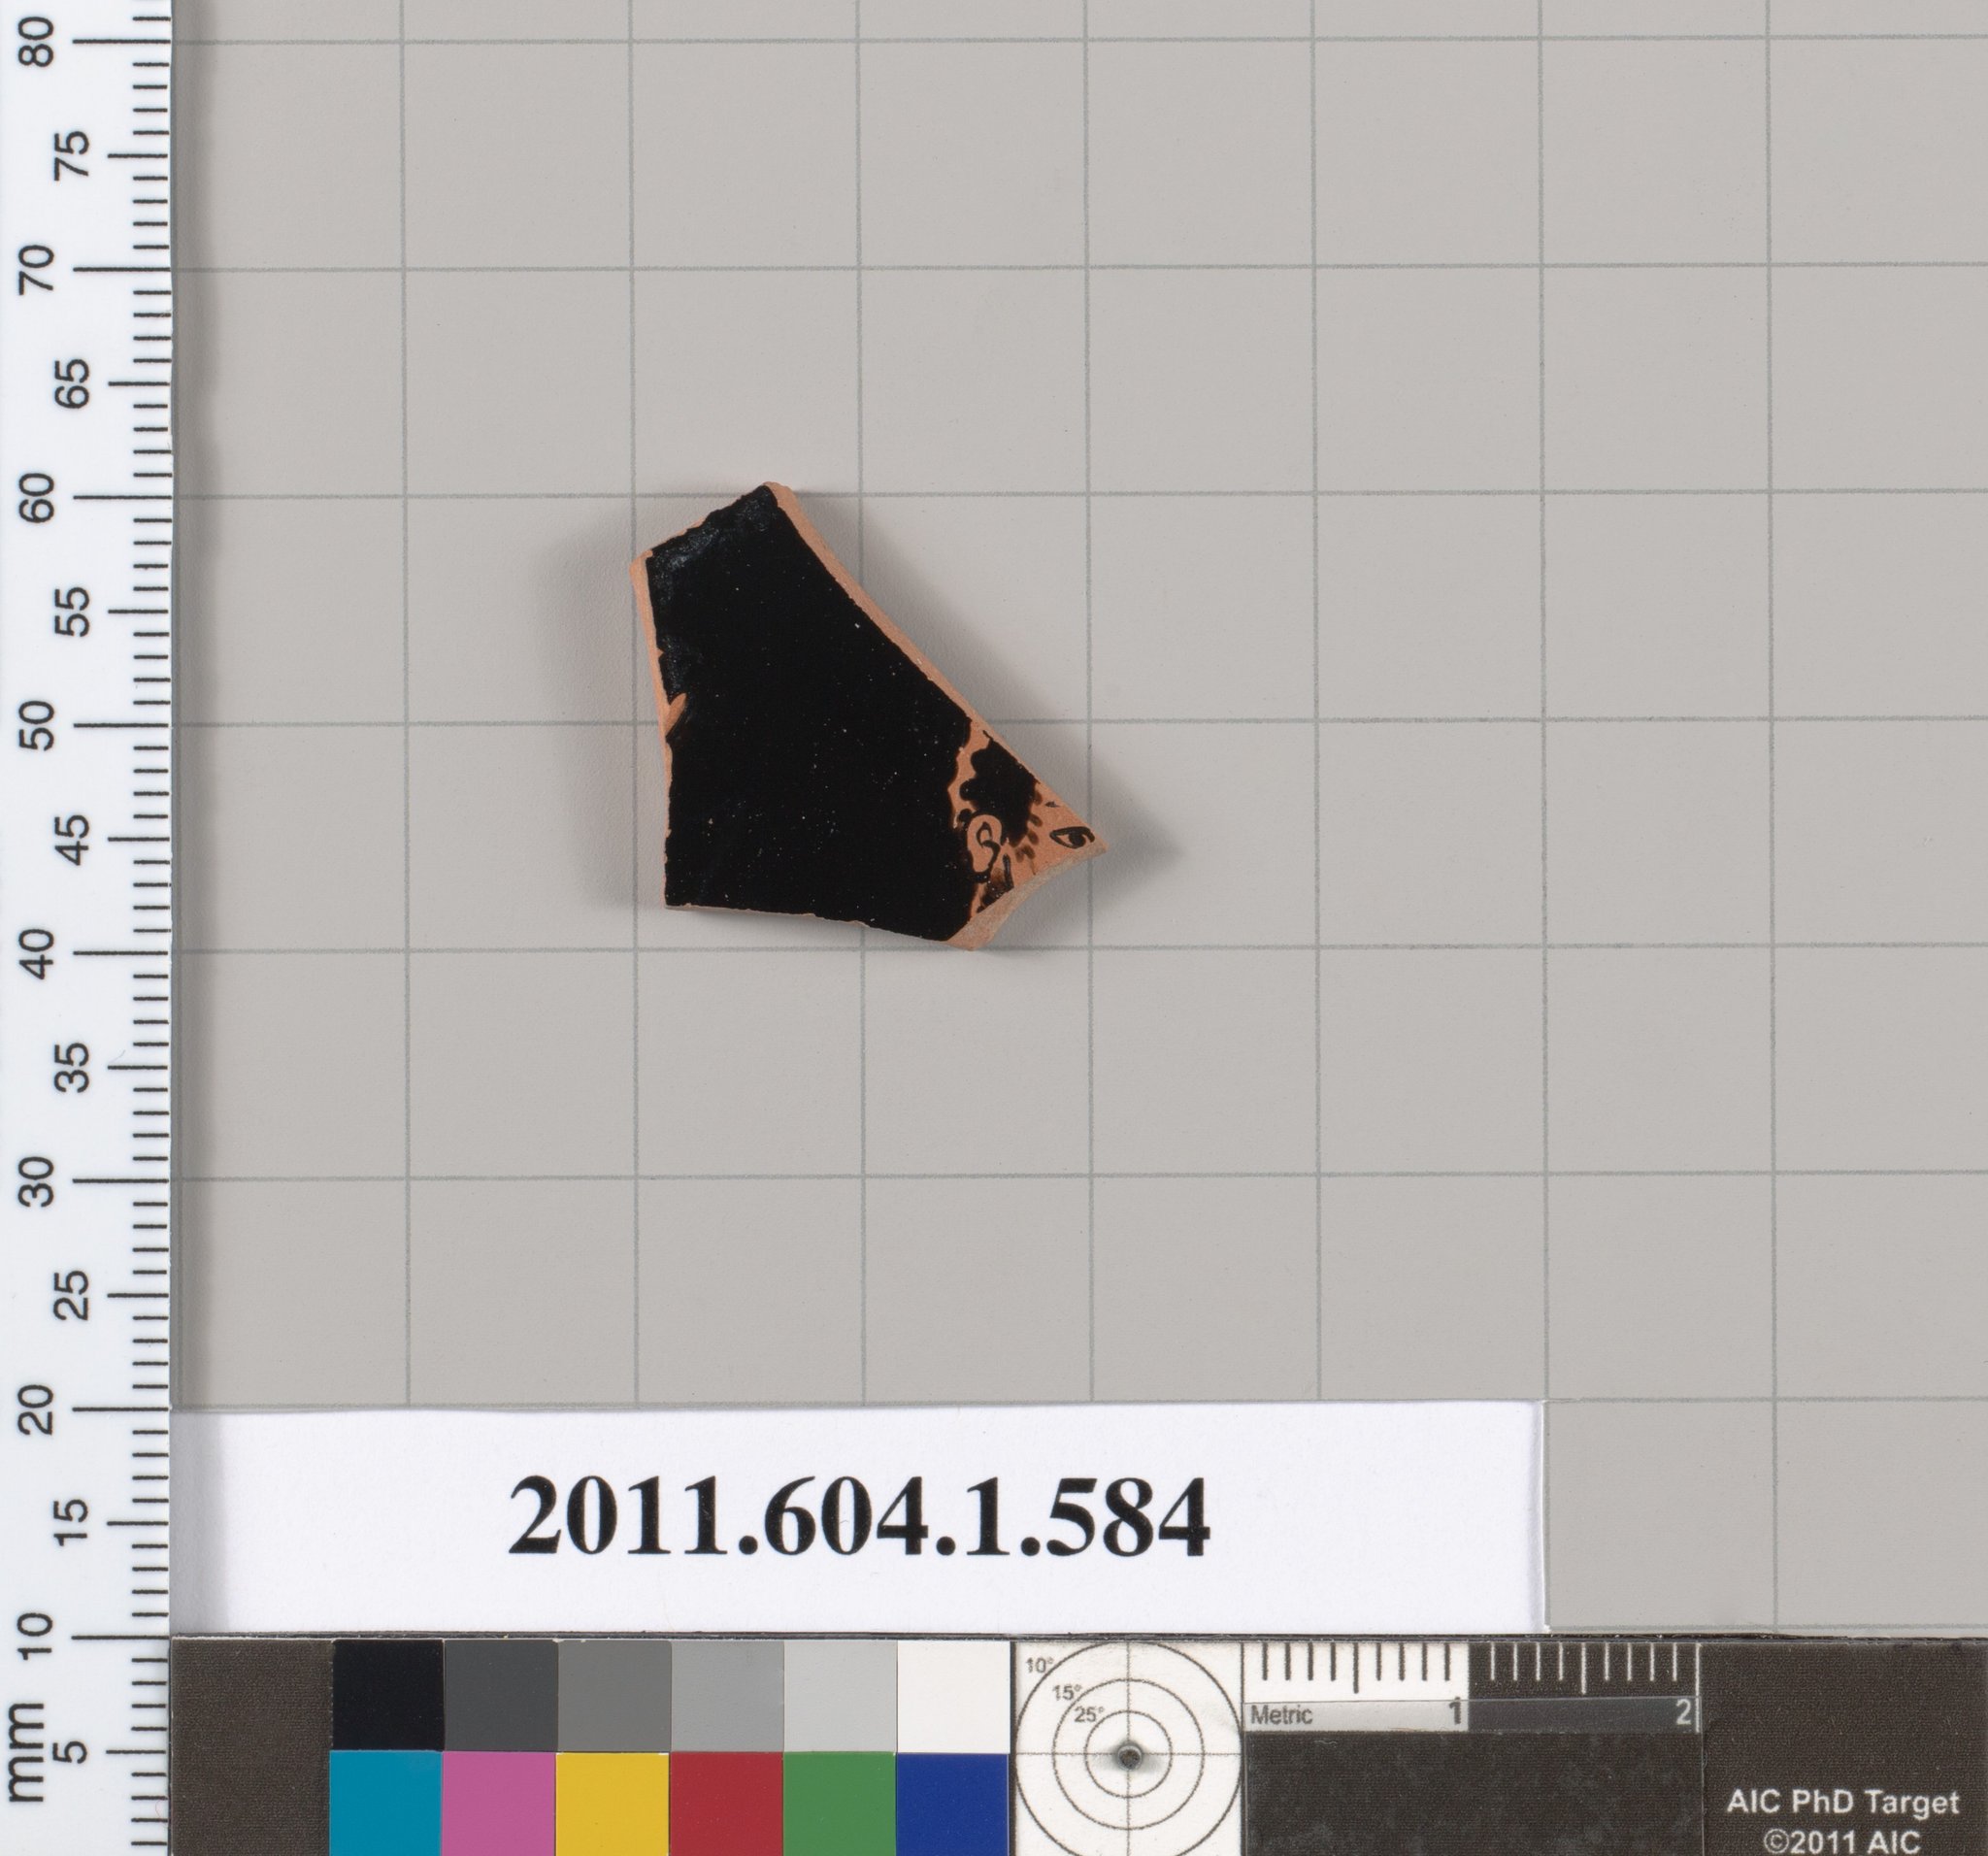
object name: kylix fragment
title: Terracotta fragment of a kylix (drinking cup)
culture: greek, attic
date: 480-470 BCE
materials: terracotta